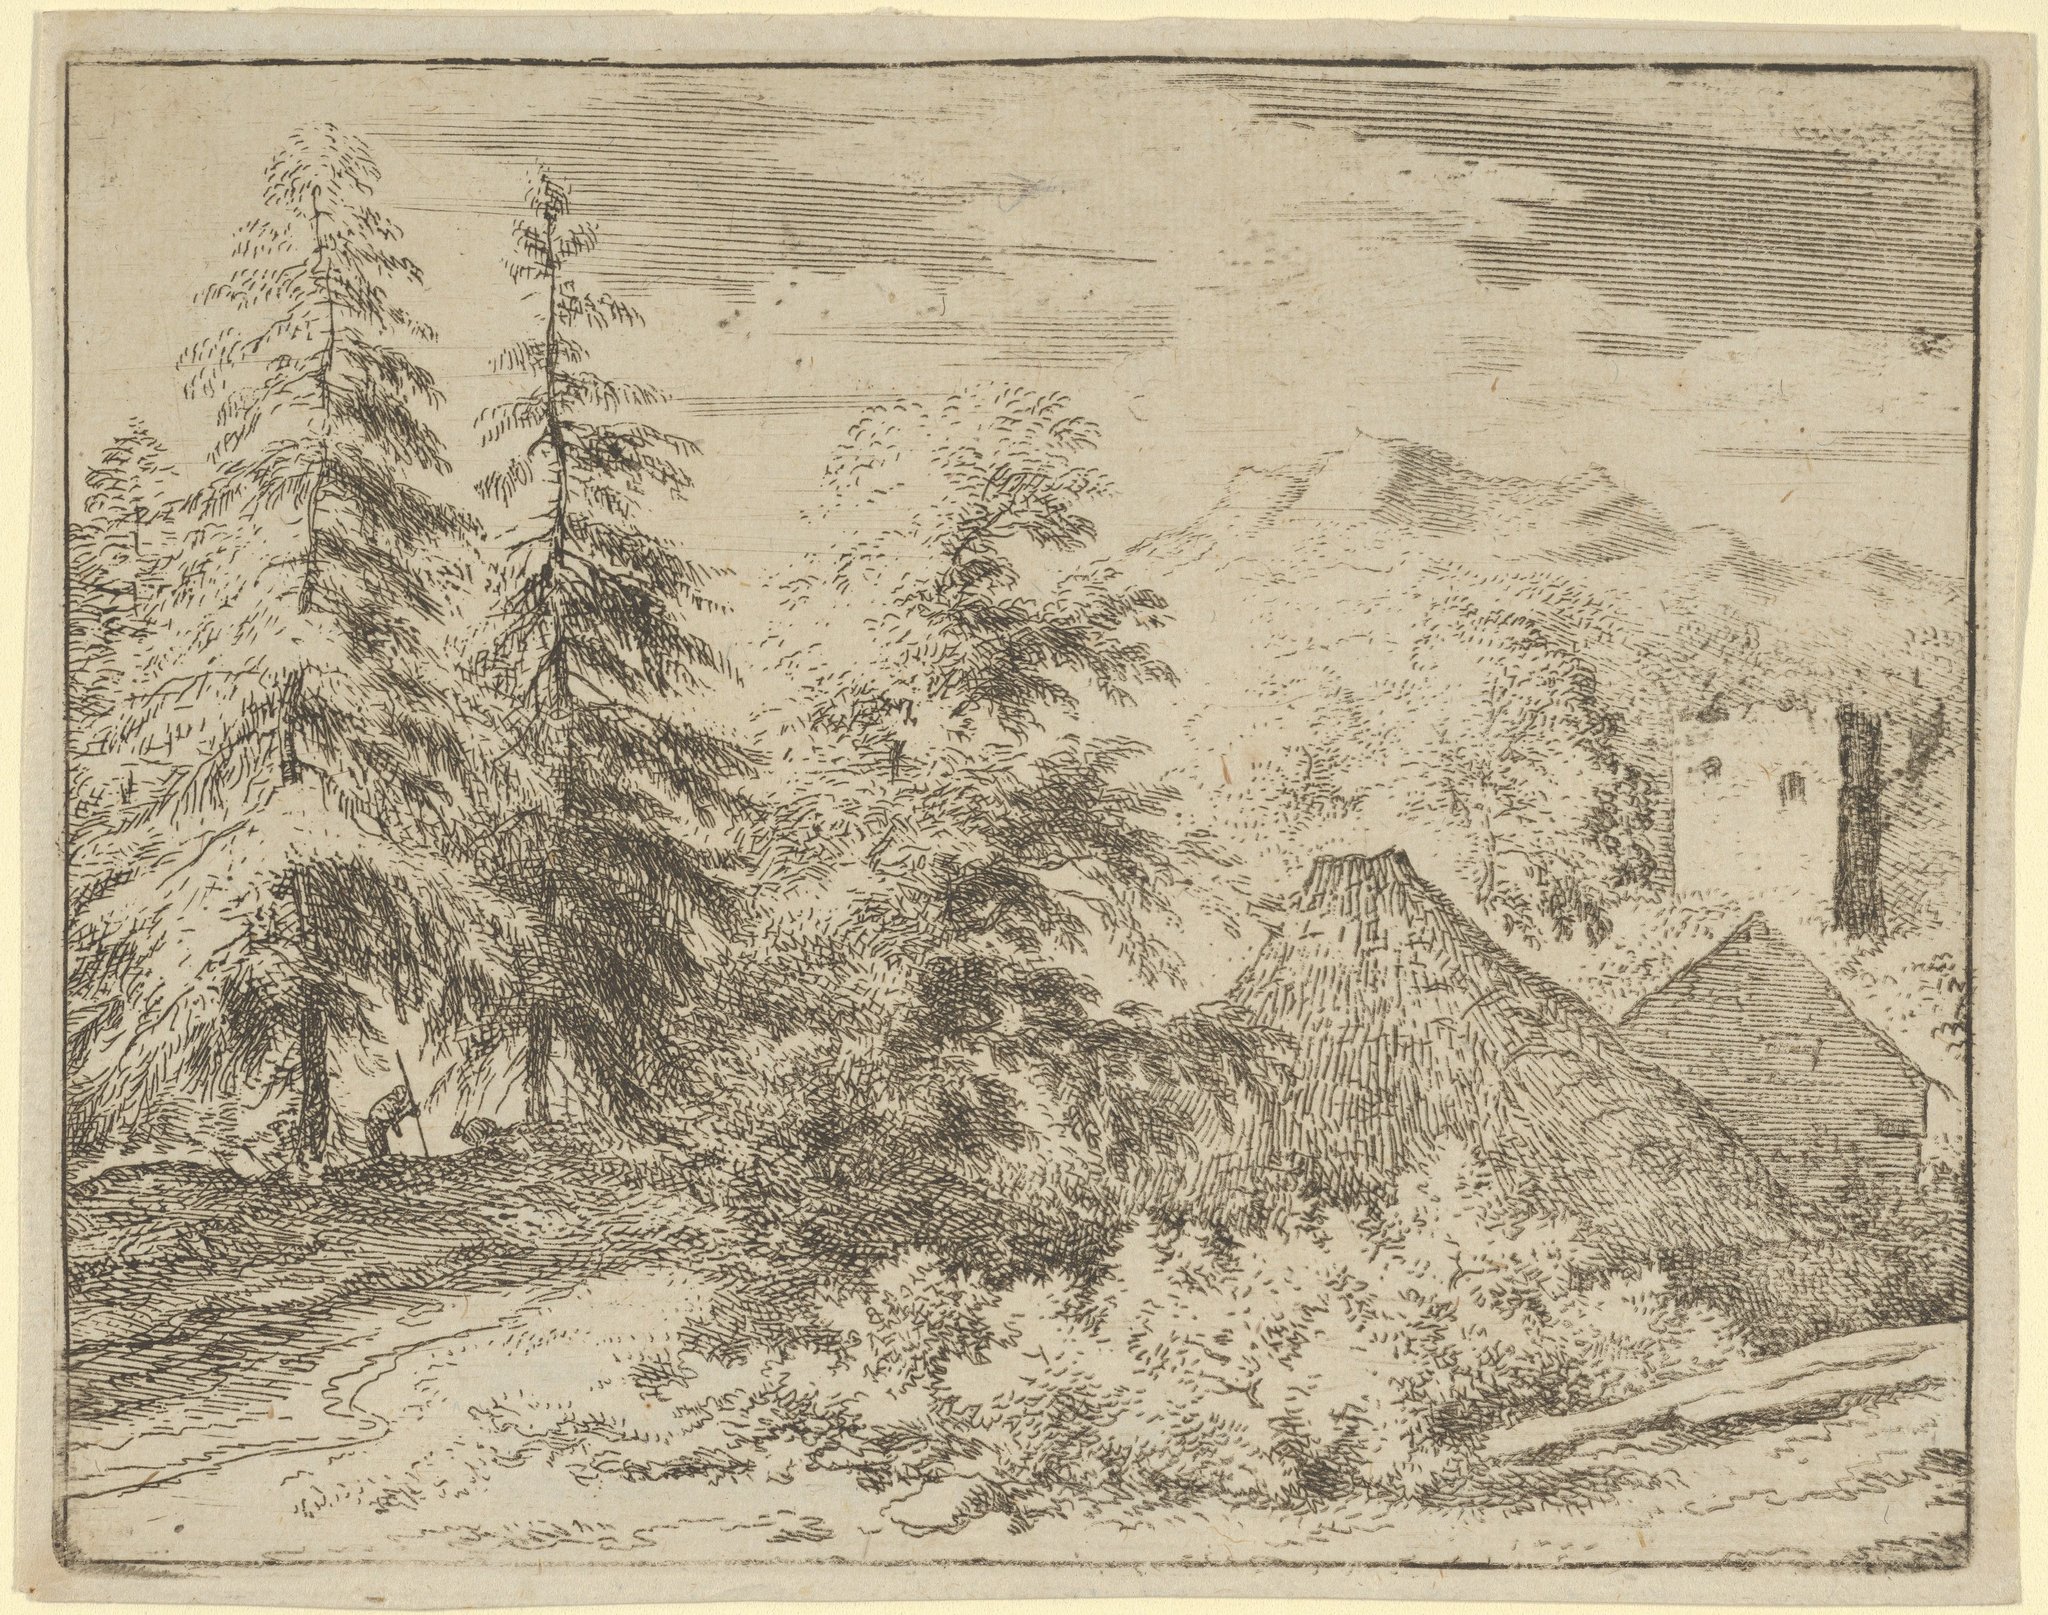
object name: print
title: The Man between the Two Fir Trees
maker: allart van everdingen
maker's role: artist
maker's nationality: dutch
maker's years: 1621-1675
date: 1621-1675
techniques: engraving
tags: men,landscapes,trees